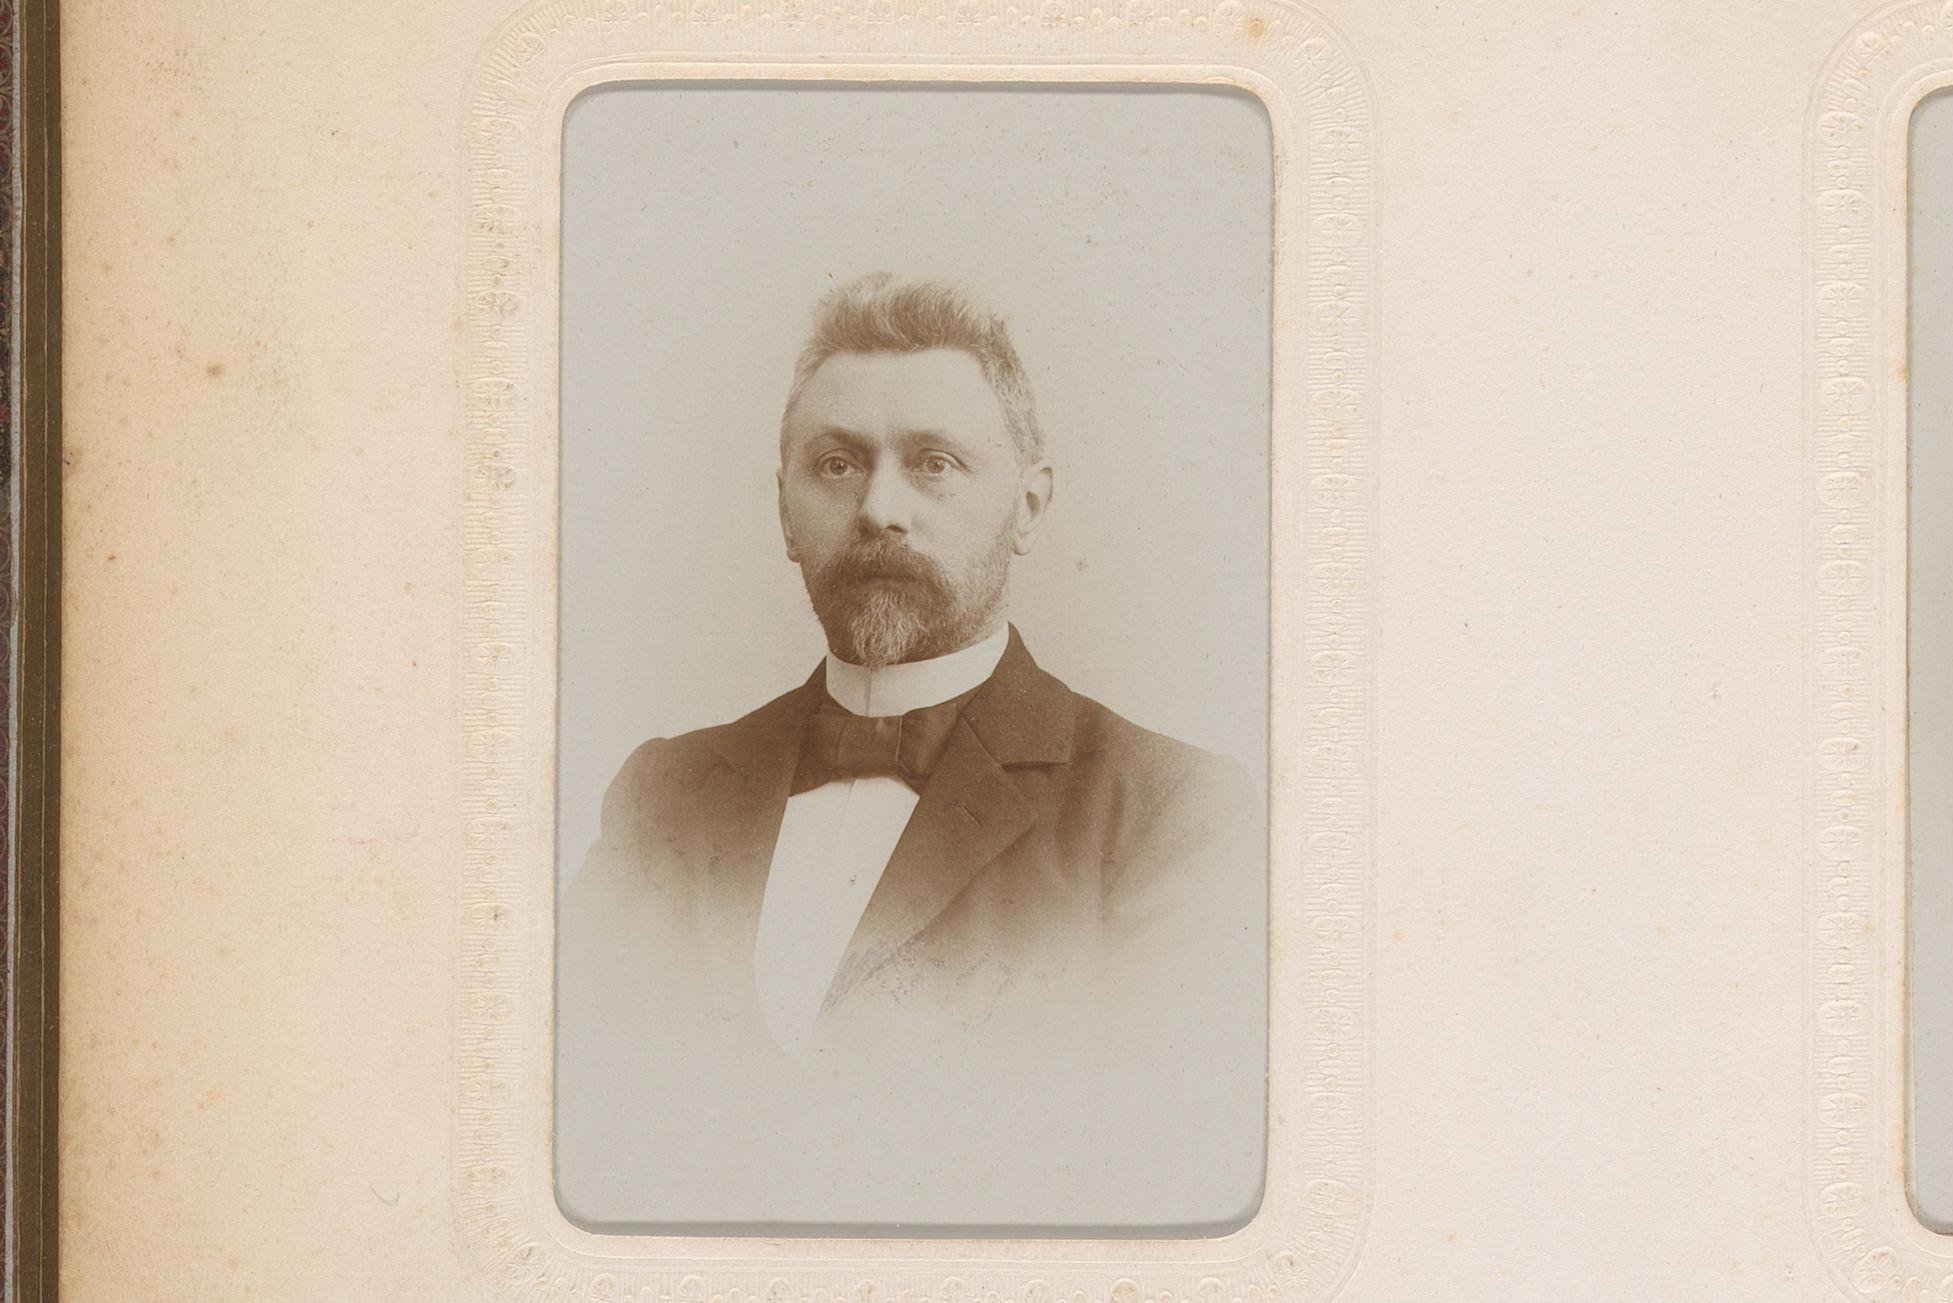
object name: photograph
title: Portret van een man met snor, baard en vlinderstrik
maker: Anonymous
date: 1880-1920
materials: cardboard, photographic support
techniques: collodion silver print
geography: netherlands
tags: moustache, historical persons, beard